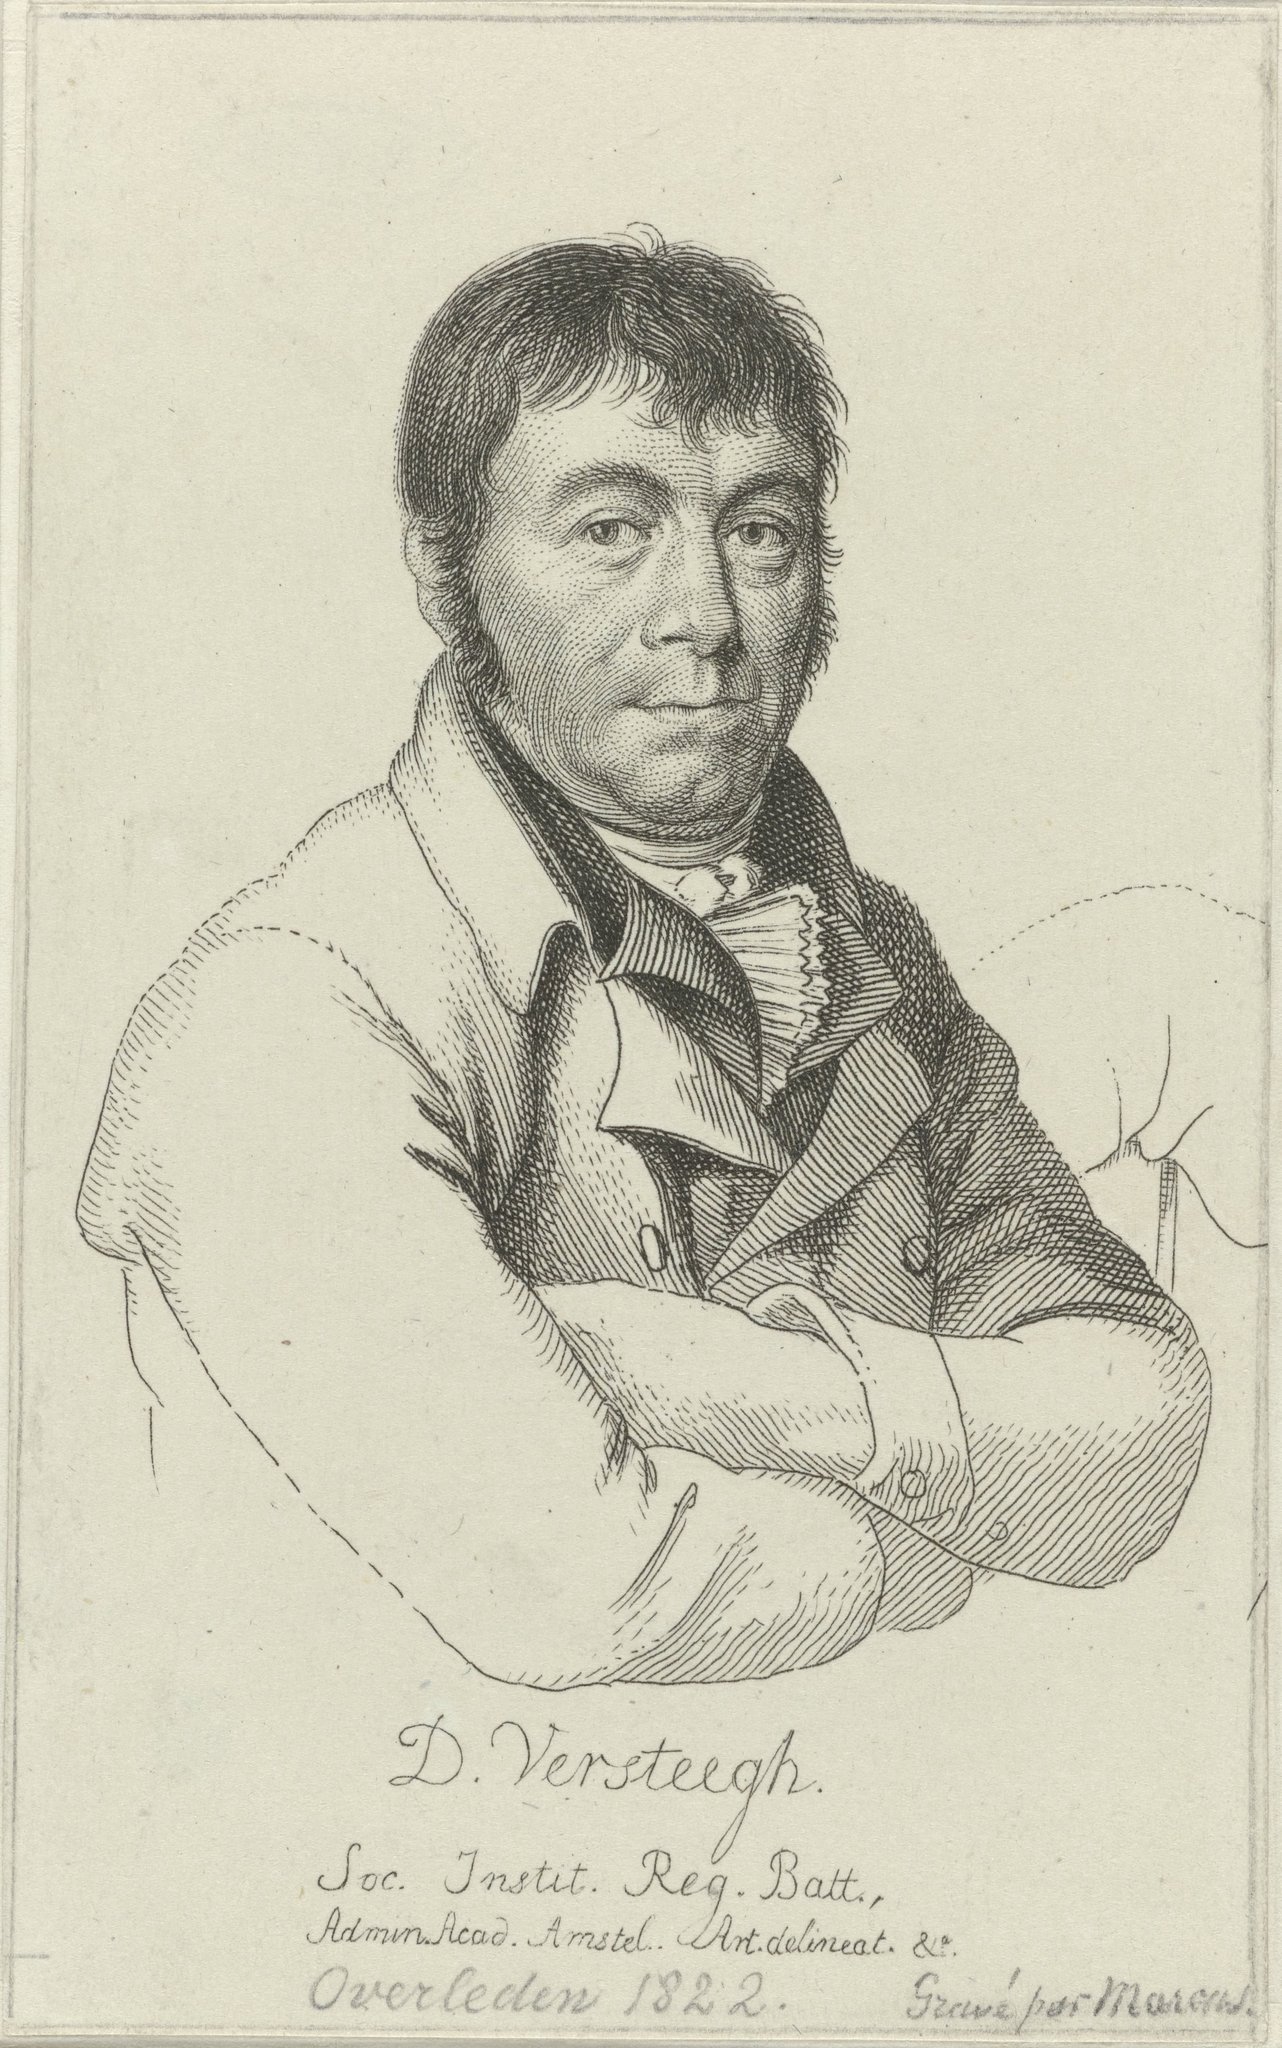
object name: print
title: Portret van de tekenaar Dirk Versteegh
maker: jacob ernst marcus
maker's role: draughtsman, print maker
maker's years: 1774-1826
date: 1784-1826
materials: paper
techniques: engraving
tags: dirk versteegh, historical persons, portrait, self-portrait of artist, portrait, self-portrait of draughtsman